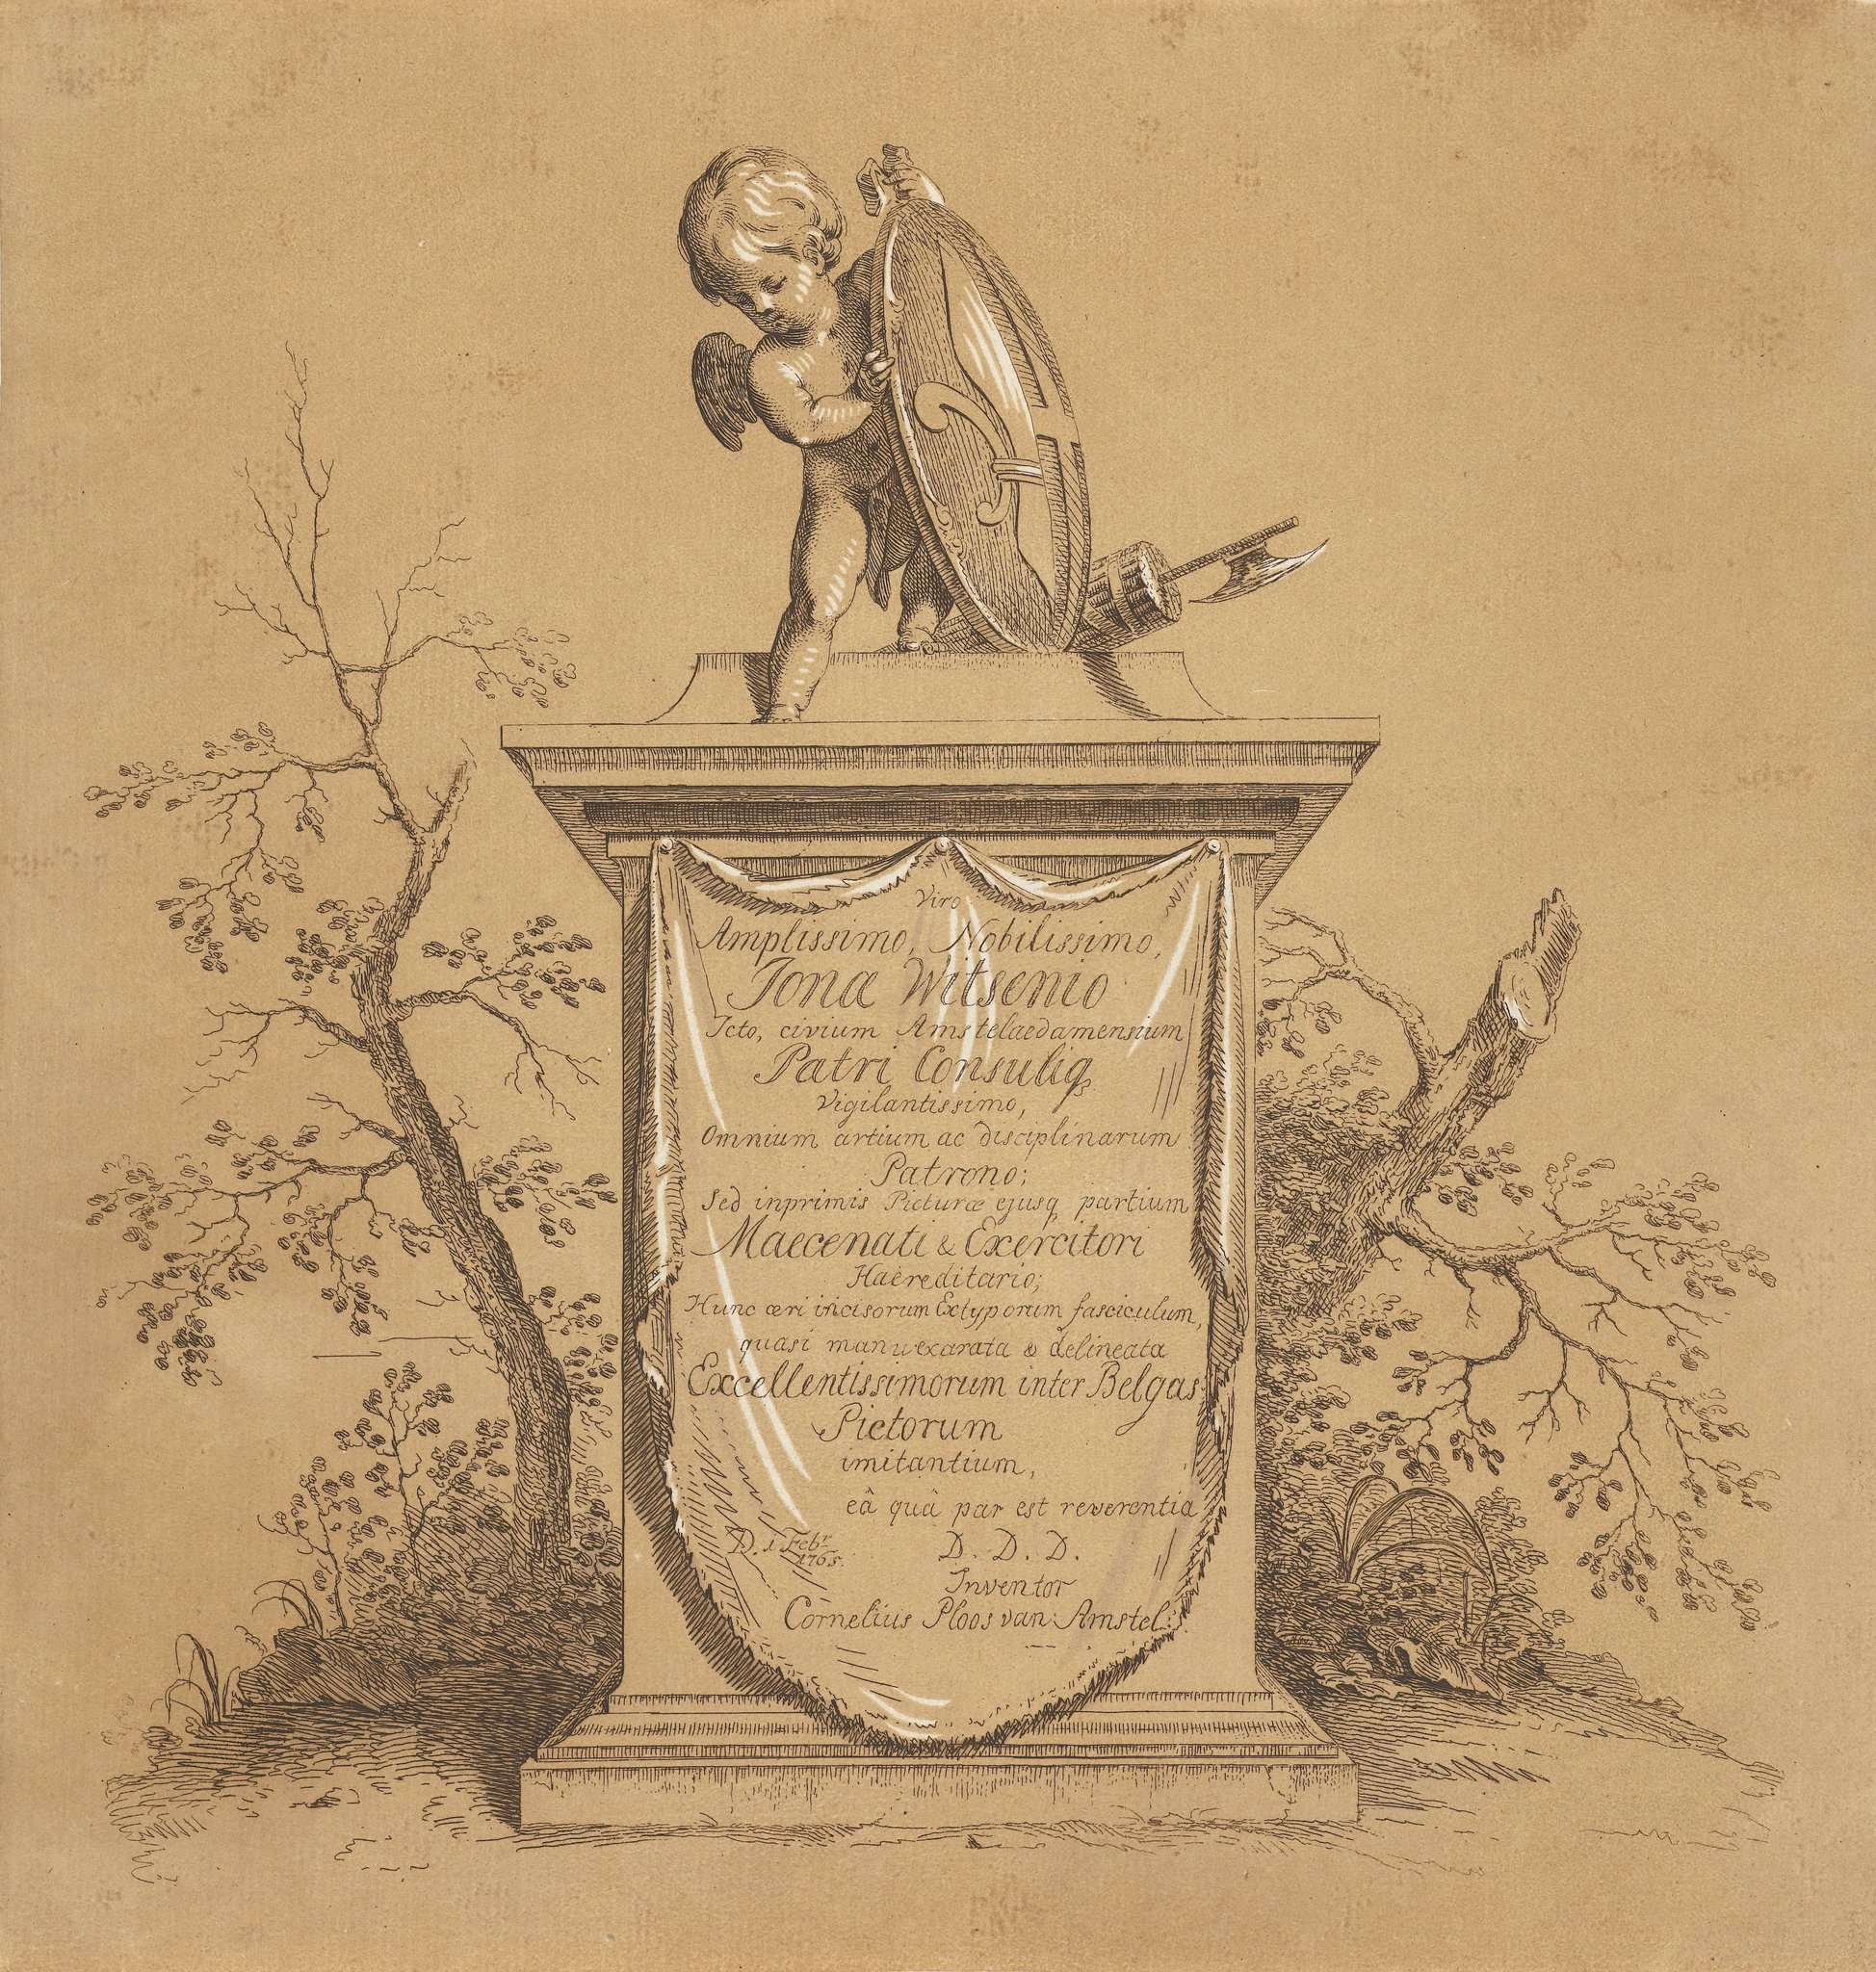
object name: print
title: Prentwerk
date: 1765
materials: paper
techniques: etching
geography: amsterdam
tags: monument, statue, cupids: 'amores', 'amoretti', 'putti'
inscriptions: collector's mark: Lugt 2725, collector's mark: Lugt 240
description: Monument met bovenop een staande putto, die een schild vasthoudt. Naast de putto een fasces.